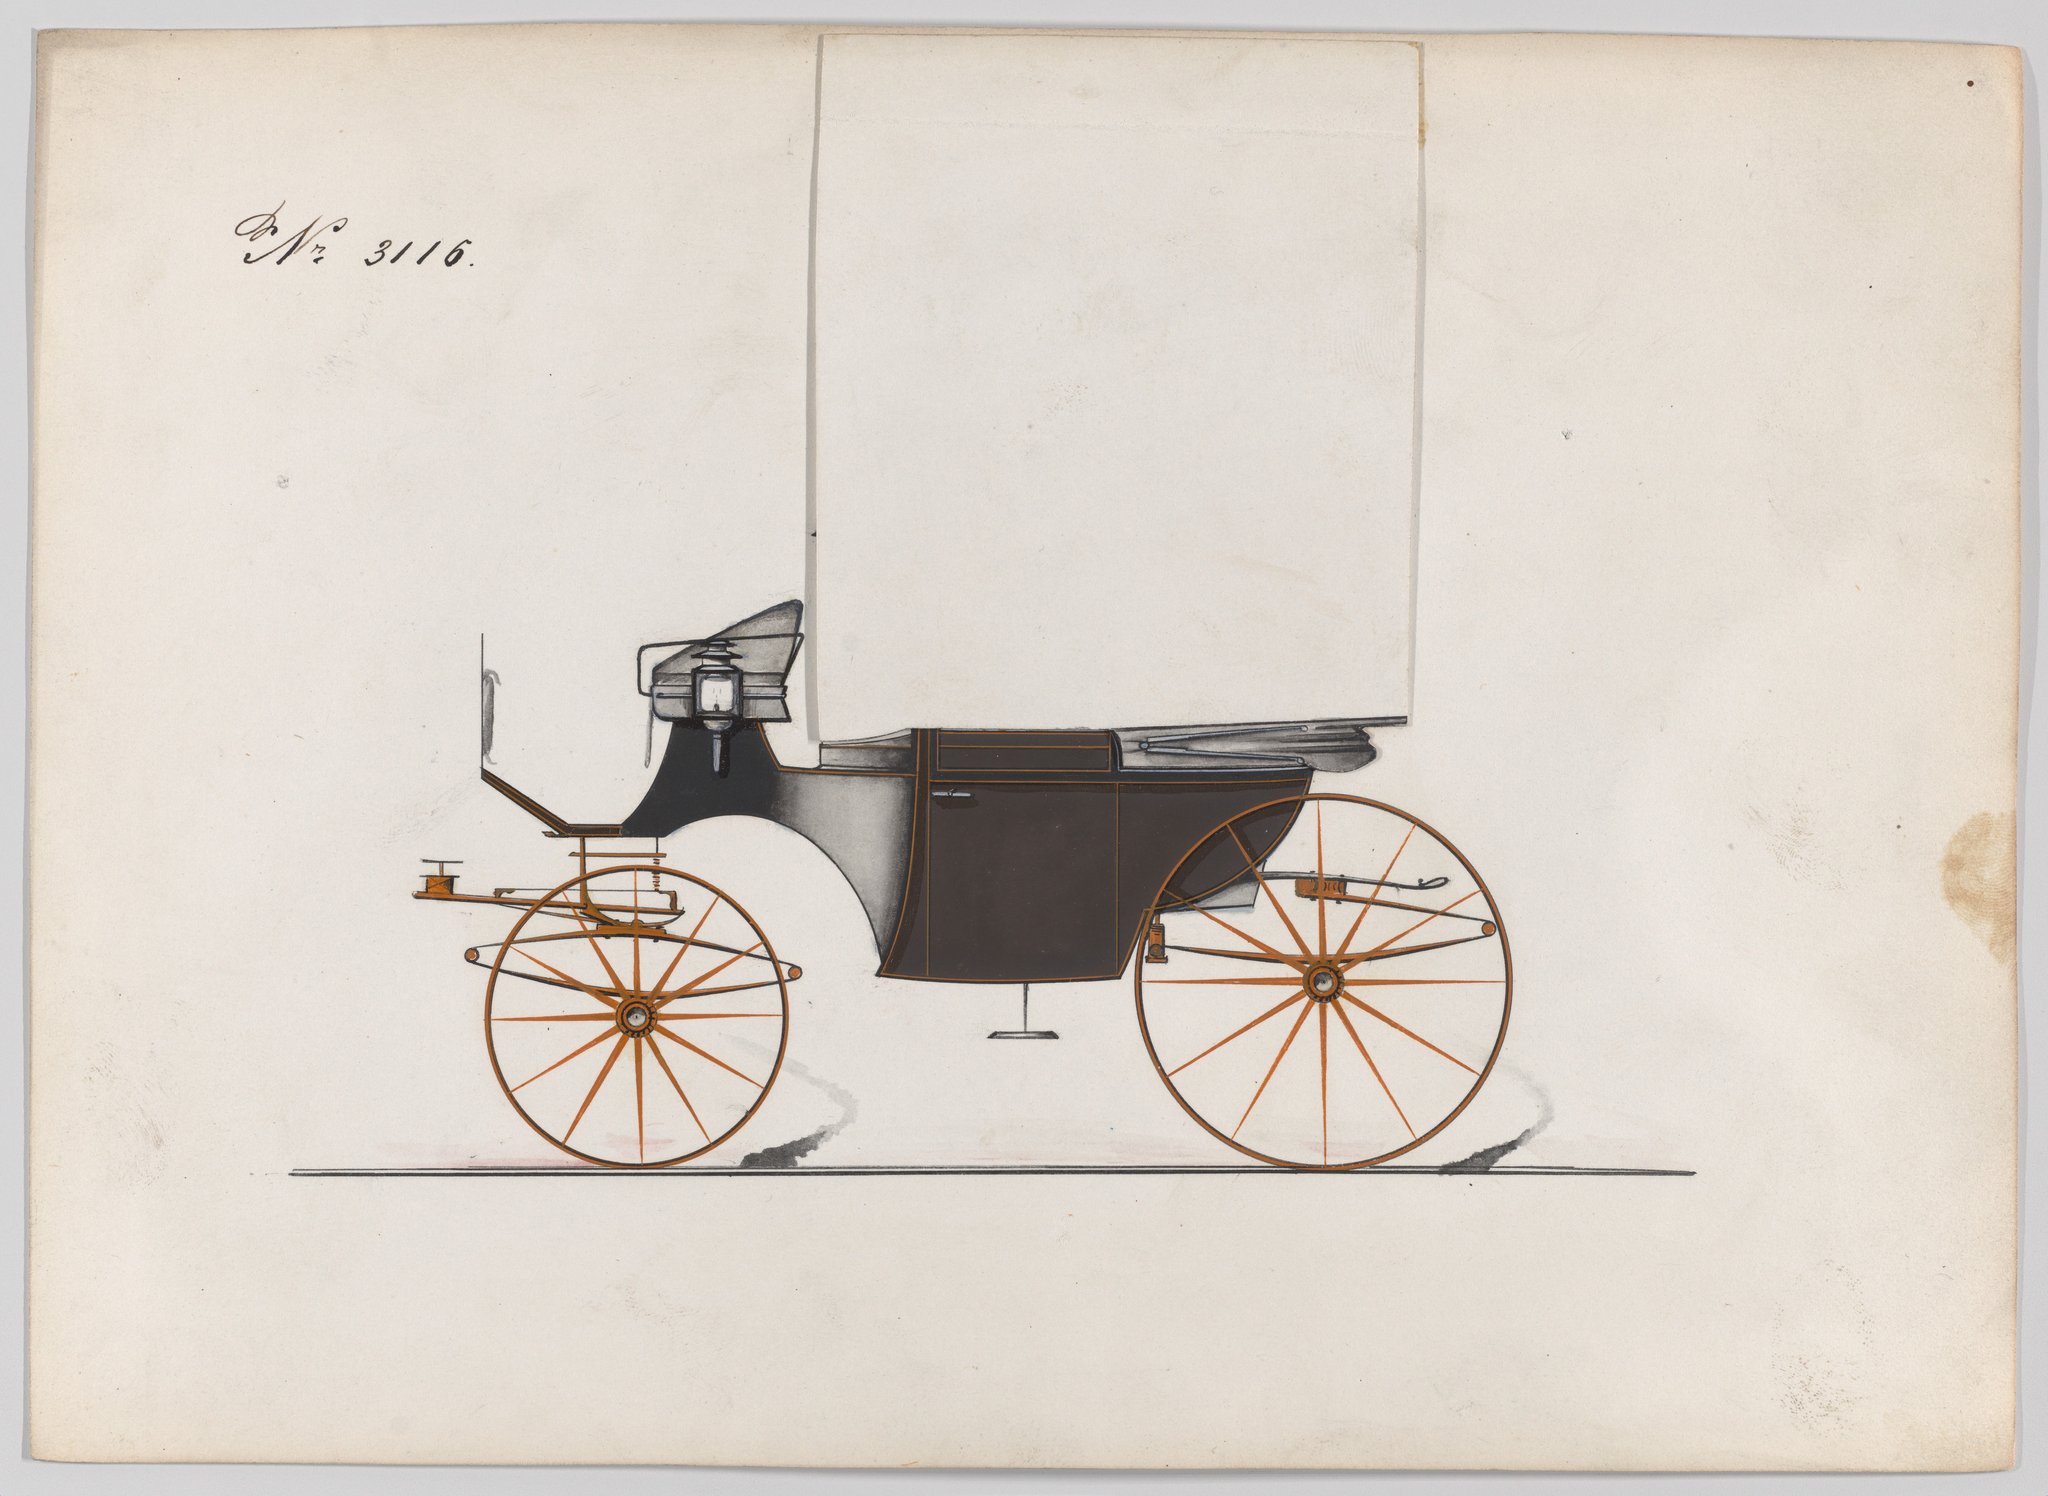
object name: drawing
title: Design for Landaulet, no. 3116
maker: brewster & co.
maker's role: manufacturer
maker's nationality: american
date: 1873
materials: gouache, gum arabic, ink, watercolor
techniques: pen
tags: carriages